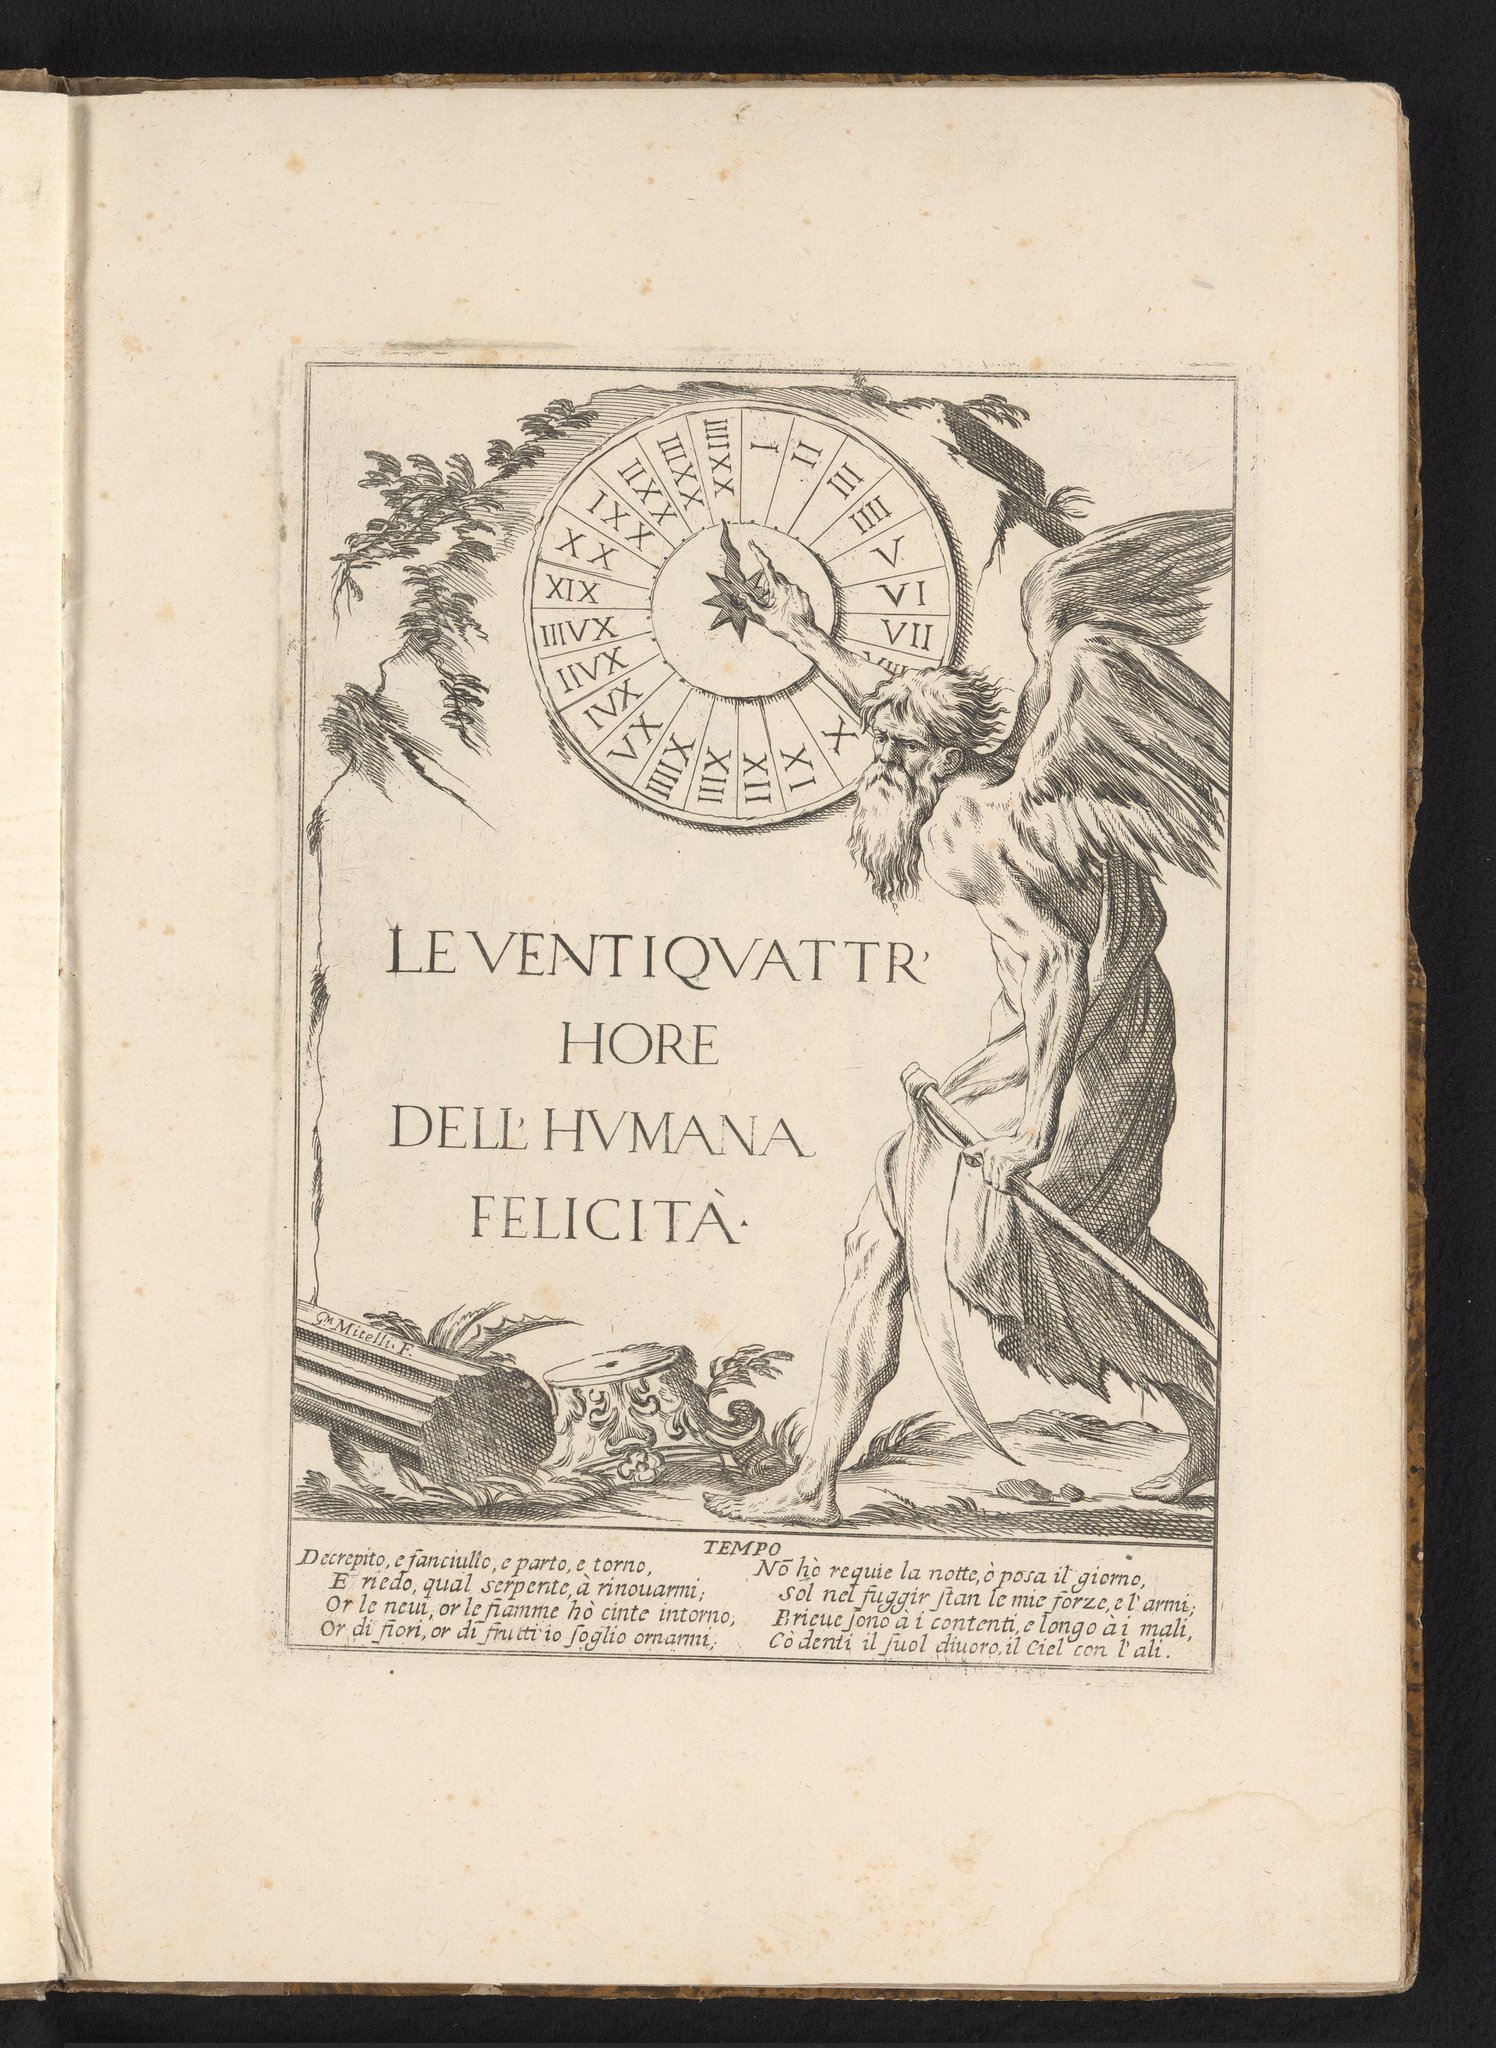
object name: titelprent, frontispice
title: Titelprent voor de serie 'De vierentwintig uren van het menselijk geluk'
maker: giuseppe maria mitelli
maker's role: draughtsman, painter, print maker, publisher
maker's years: 1634-1718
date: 1675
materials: paper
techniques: engraving, etching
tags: scenes symbolizing 'vanitas', the 24 hours of day and night, clock, father time, man with wings and scythe, personifications ~ the life of man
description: Vader Tijd (Tempo) wijst naar de wijzers van een klok. Met twee vierregelige verzen in het Italiaans. Titelprent voor de serie 'De vierentwintig uren van het menselijk geluk'.